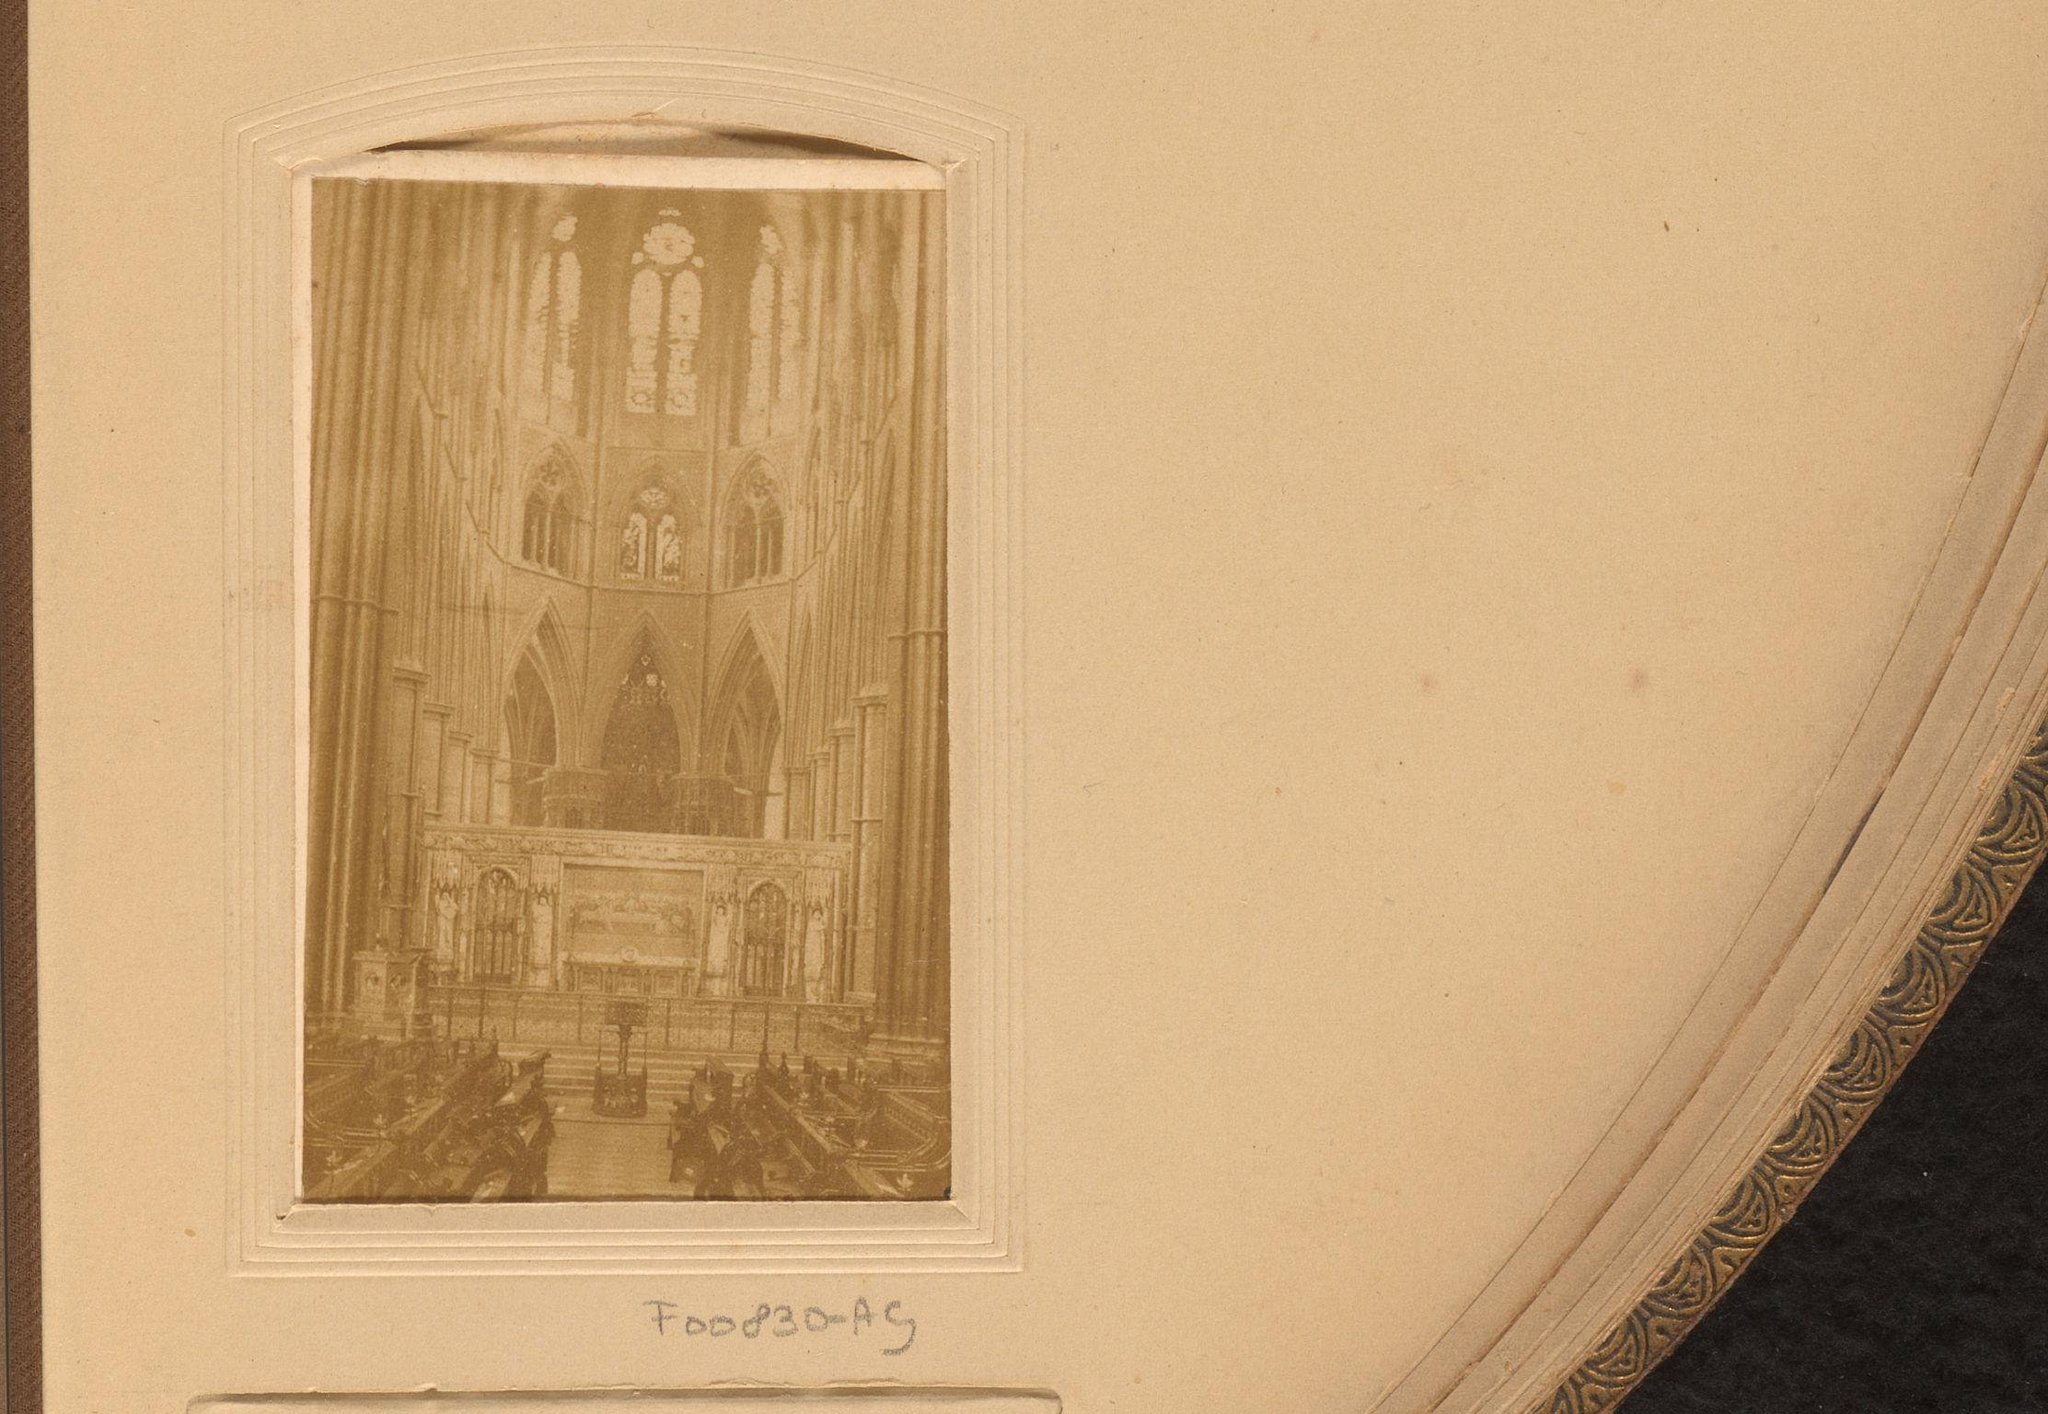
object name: carte de visite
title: Interieur van een kathedraal, middenschip met oksaal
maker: Anonymous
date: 1870-1910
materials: cardboard, photographic support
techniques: albumen print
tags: parts of church interior: nave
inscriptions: annotation: ‘?’